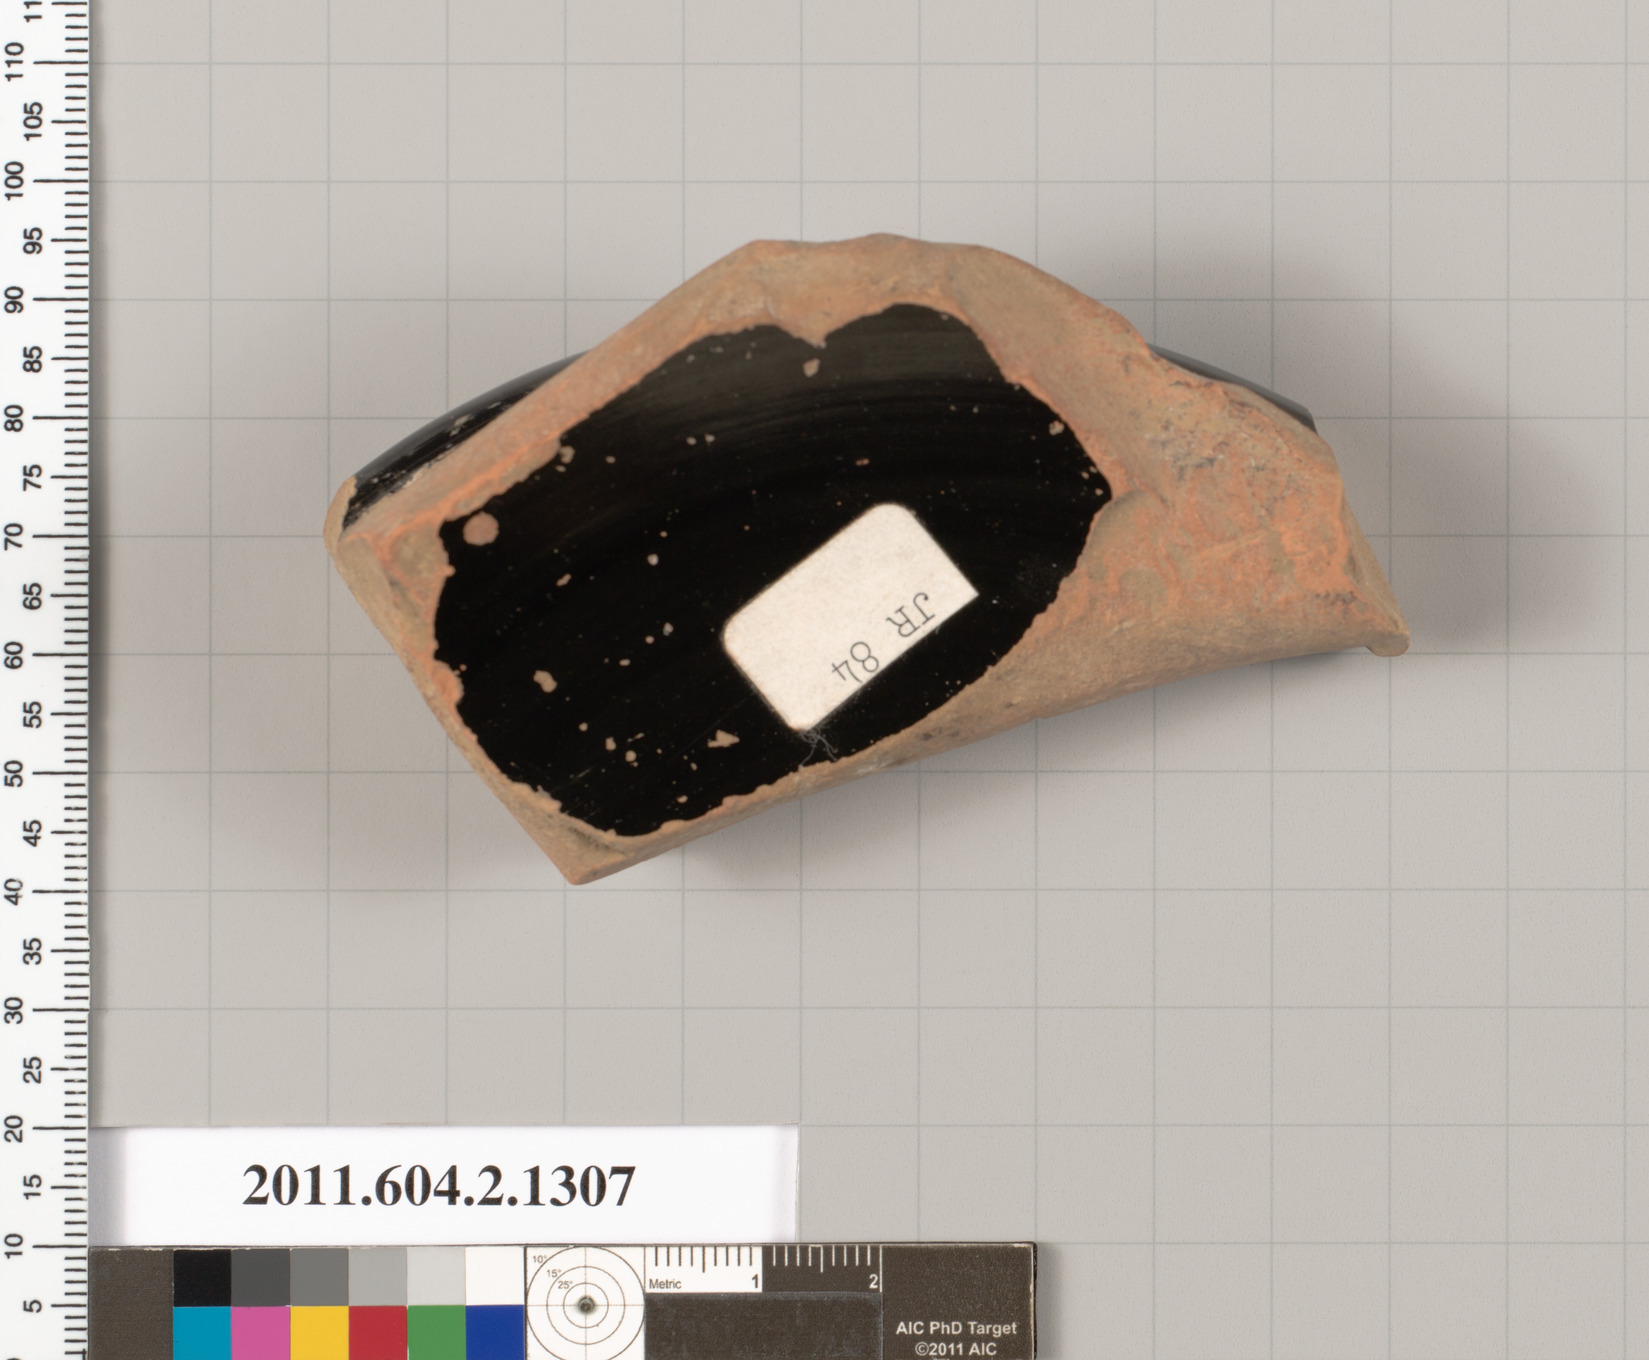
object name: skyphos fragment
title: Terracotta fragment of a skyphos (deep drinking cup)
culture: greek, attic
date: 500-451 BCE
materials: terracotta